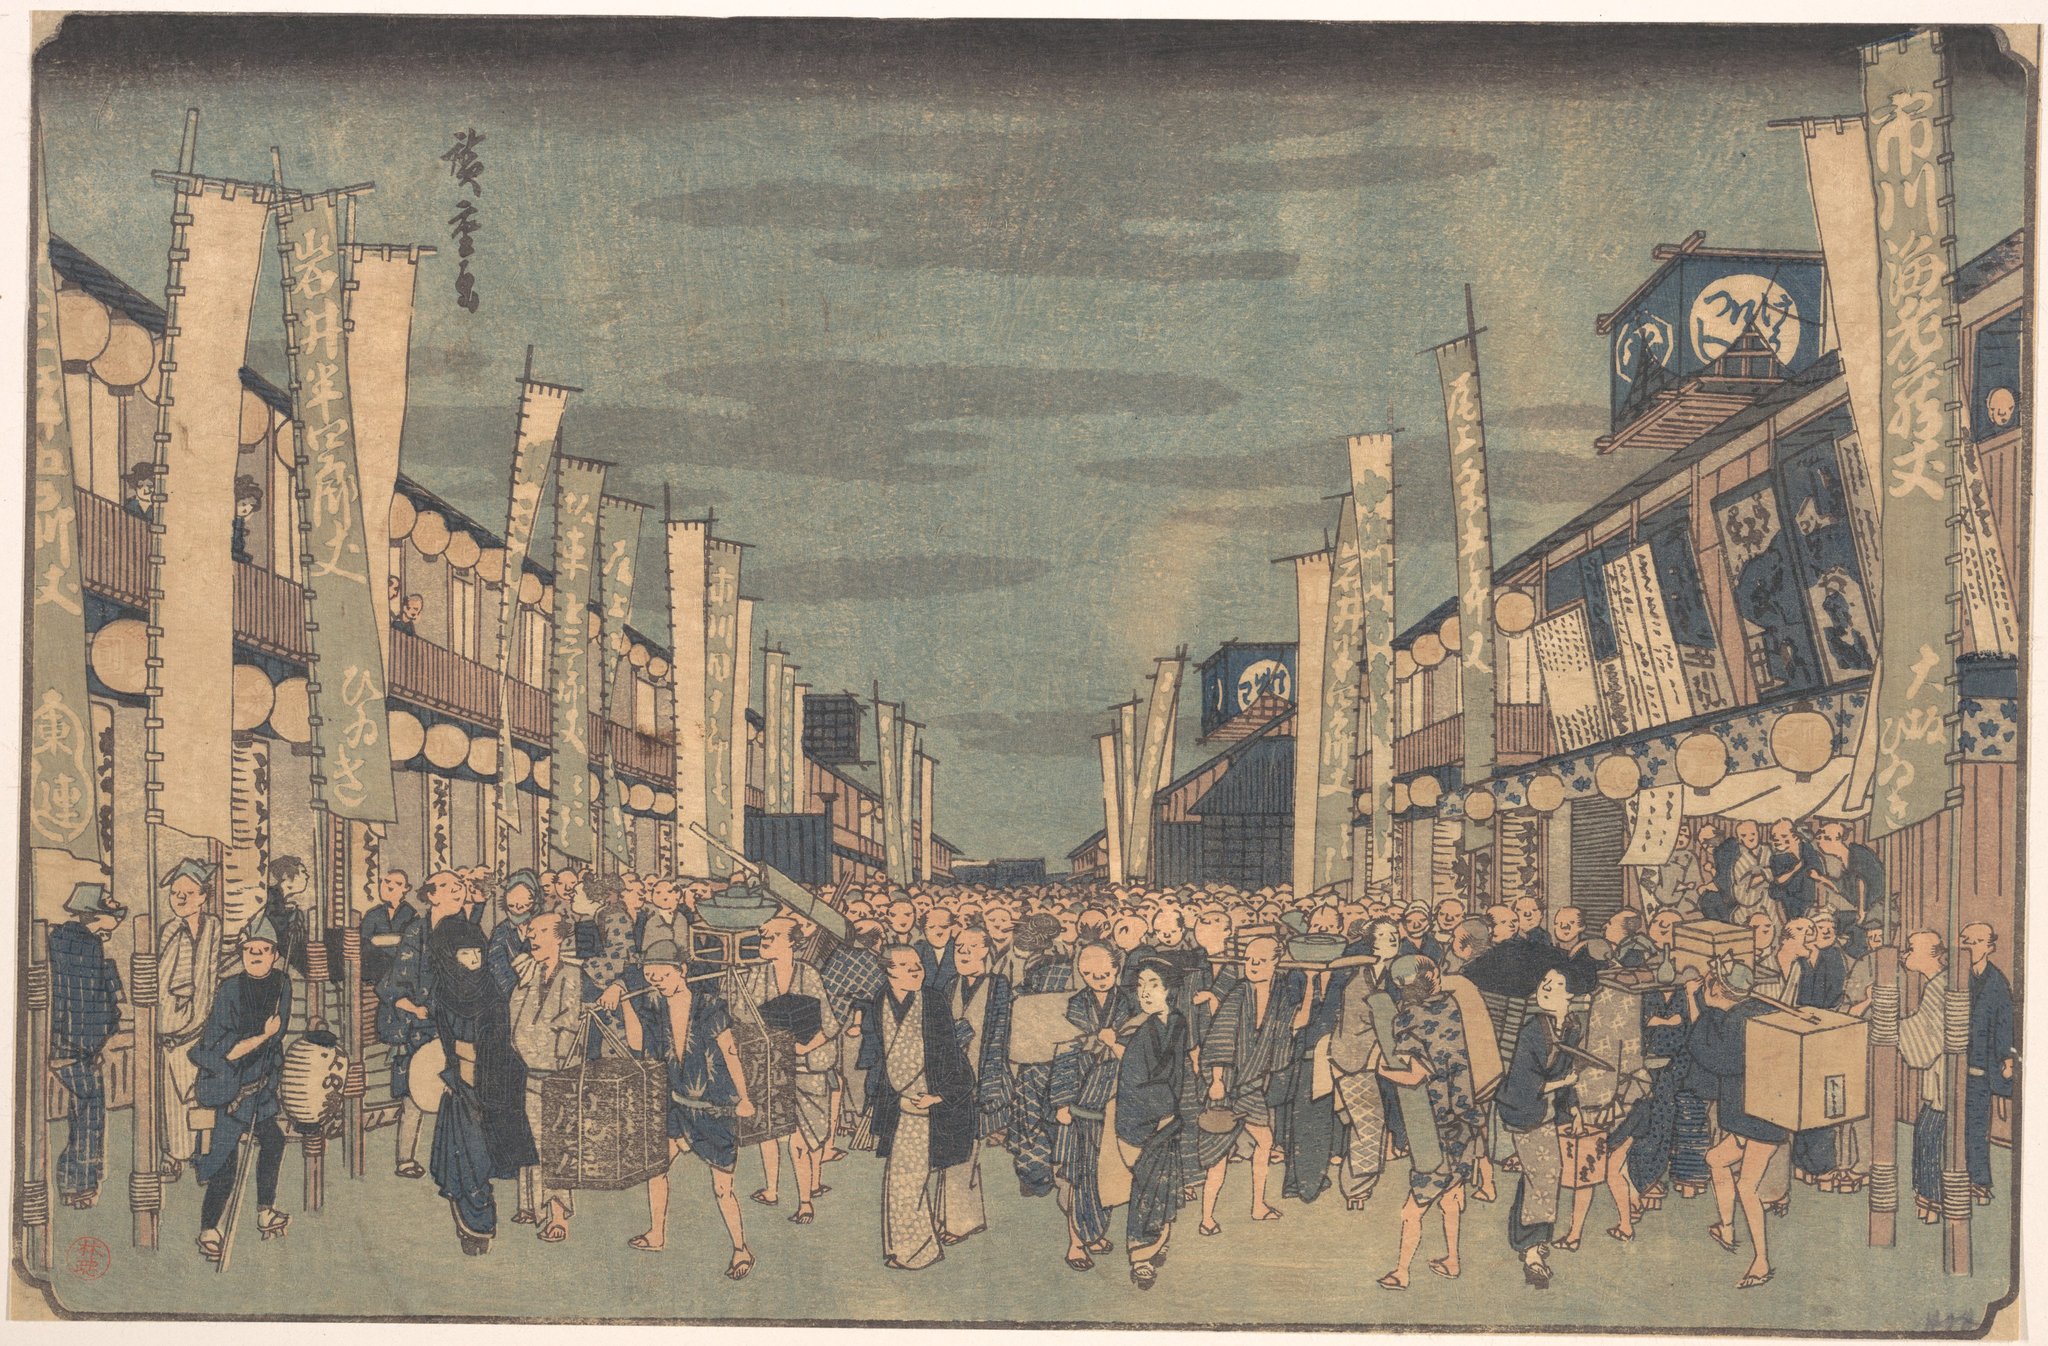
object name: print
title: Picture of the Theatres in Sakai Cho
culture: japanese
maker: utagawa hiroshige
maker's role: artist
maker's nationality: japanese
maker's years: 1797-1858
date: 1797-1858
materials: ink, paper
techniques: woodblock print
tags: roads,men,women,crowd